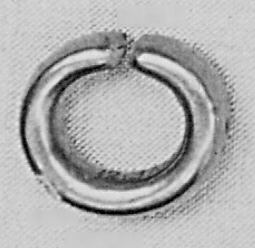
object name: earring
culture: japanese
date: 601-700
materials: gold